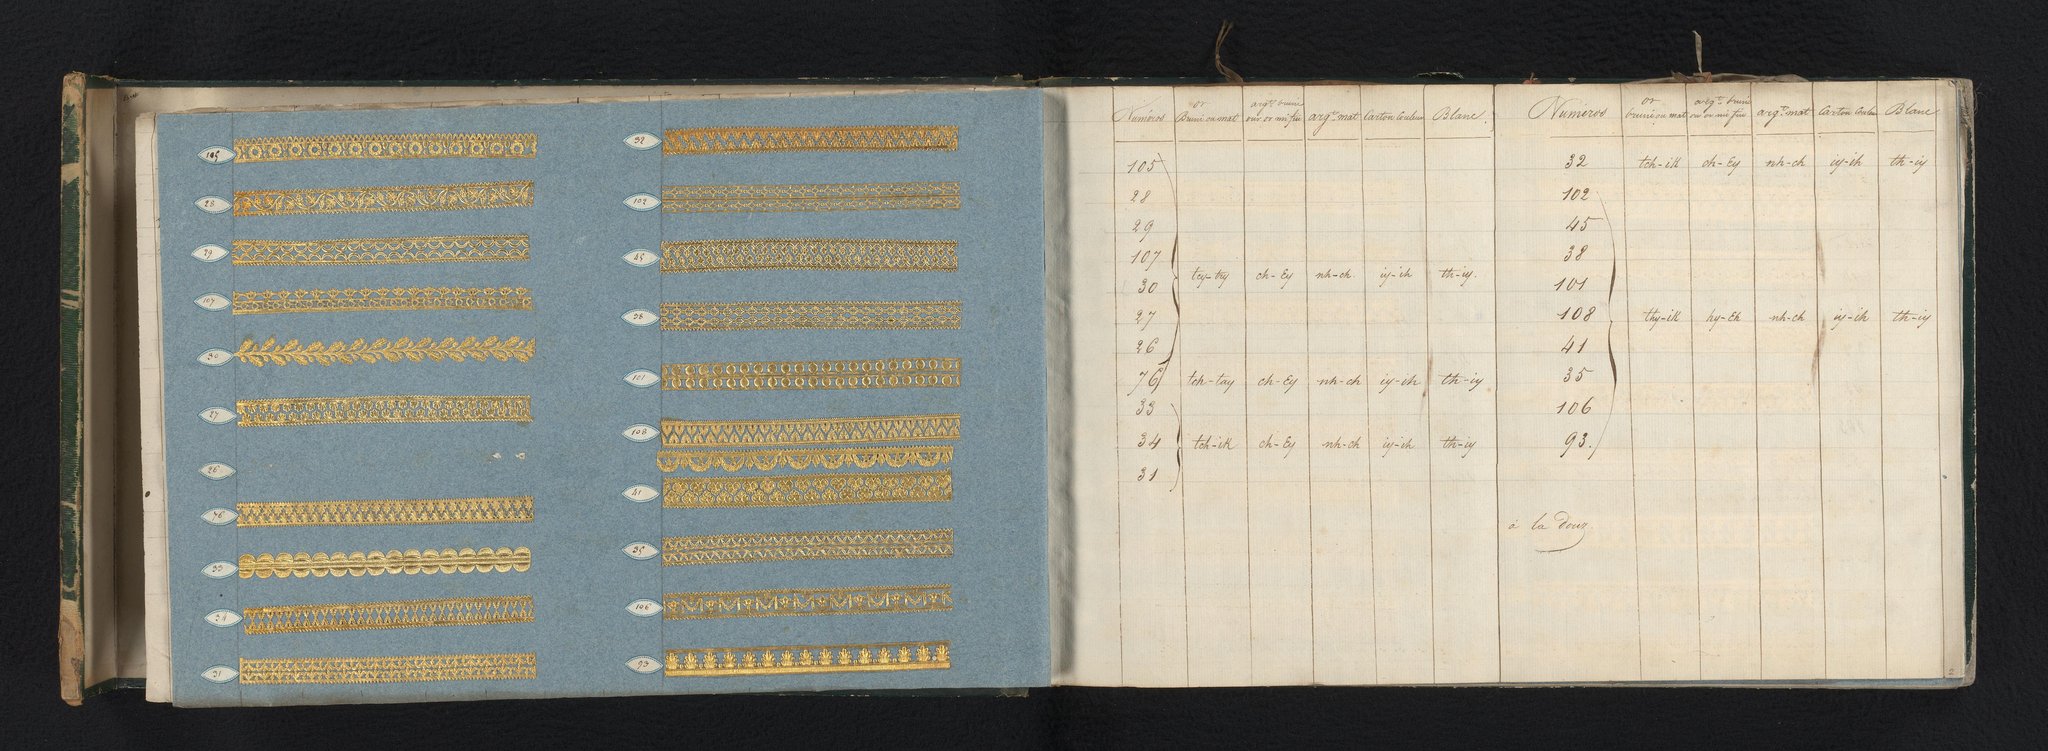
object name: manuscript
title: Twee bladzijden met stalen van sierlijsten van goudkleurig metaalpapier en bijbehorend tabel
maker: Anonymous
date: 1830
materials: gold leaf, ink, paper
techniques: manufacturing, writing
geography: france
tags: ornaments ~ art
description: Twee bladzijden met links 21 opgeplakte en met etiketten genummerde (109-93) stalen van sierlijsten van goudkleurig metaalpapier (staal nr. 26 ontbreekt). Op de tegenoverliggende rechterbladzijde een tabel met de handgeschreven corresponderende specificaties (in code) per ornament. Onderdeel van het stalenboek geschonken door de dames Van Rijn, vermoedelijk van een Franse papierfabrikant van luxe papieren, of diens vertegenwoordiger in Nederland, ca. 1830.